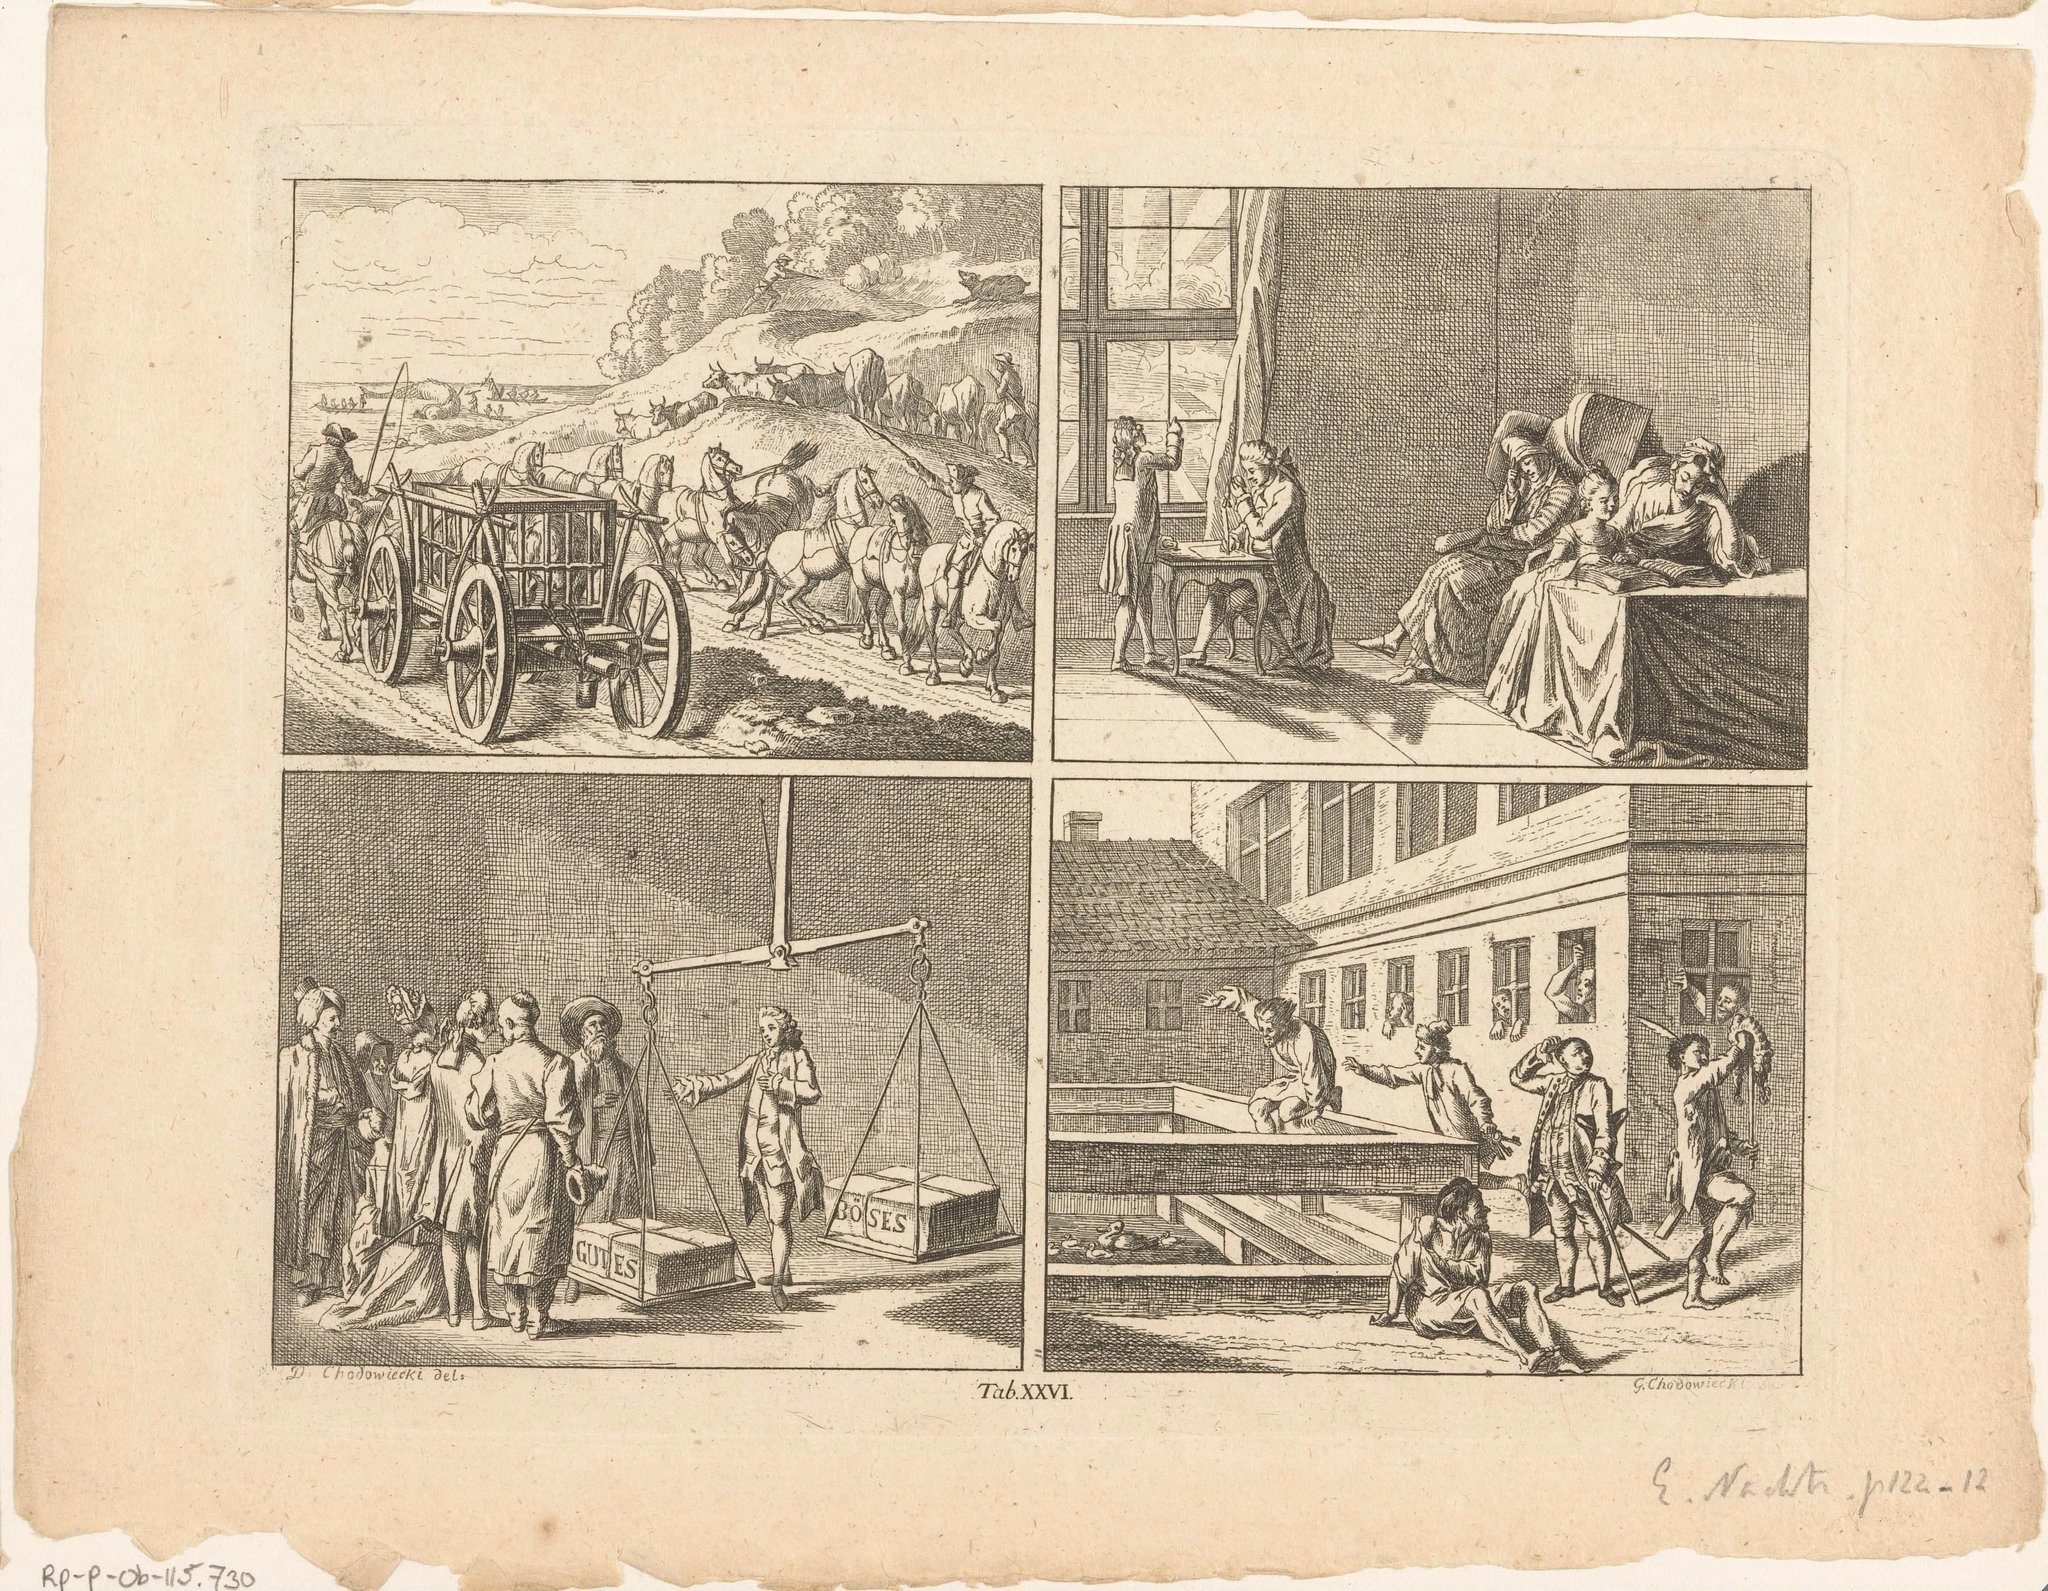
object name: book illustration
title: Vier voorstellingen over de vindingrijkheid van de mens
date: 1774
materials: paper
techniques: etching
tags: reasoning, taming and training of animals, folly, foolishness; 'pazzia', 'sciocchezza', 'stoltitia' (ripa), education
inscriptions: collector's mark: Lugt 2228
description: Prent uit: Basedow, Johann Bernhard. Kupfersammlung zu J.B. Basedows Elementarwerke für die Jugend und ihre Freunde (...). Berlijn en Dessau: s.n., 1774.